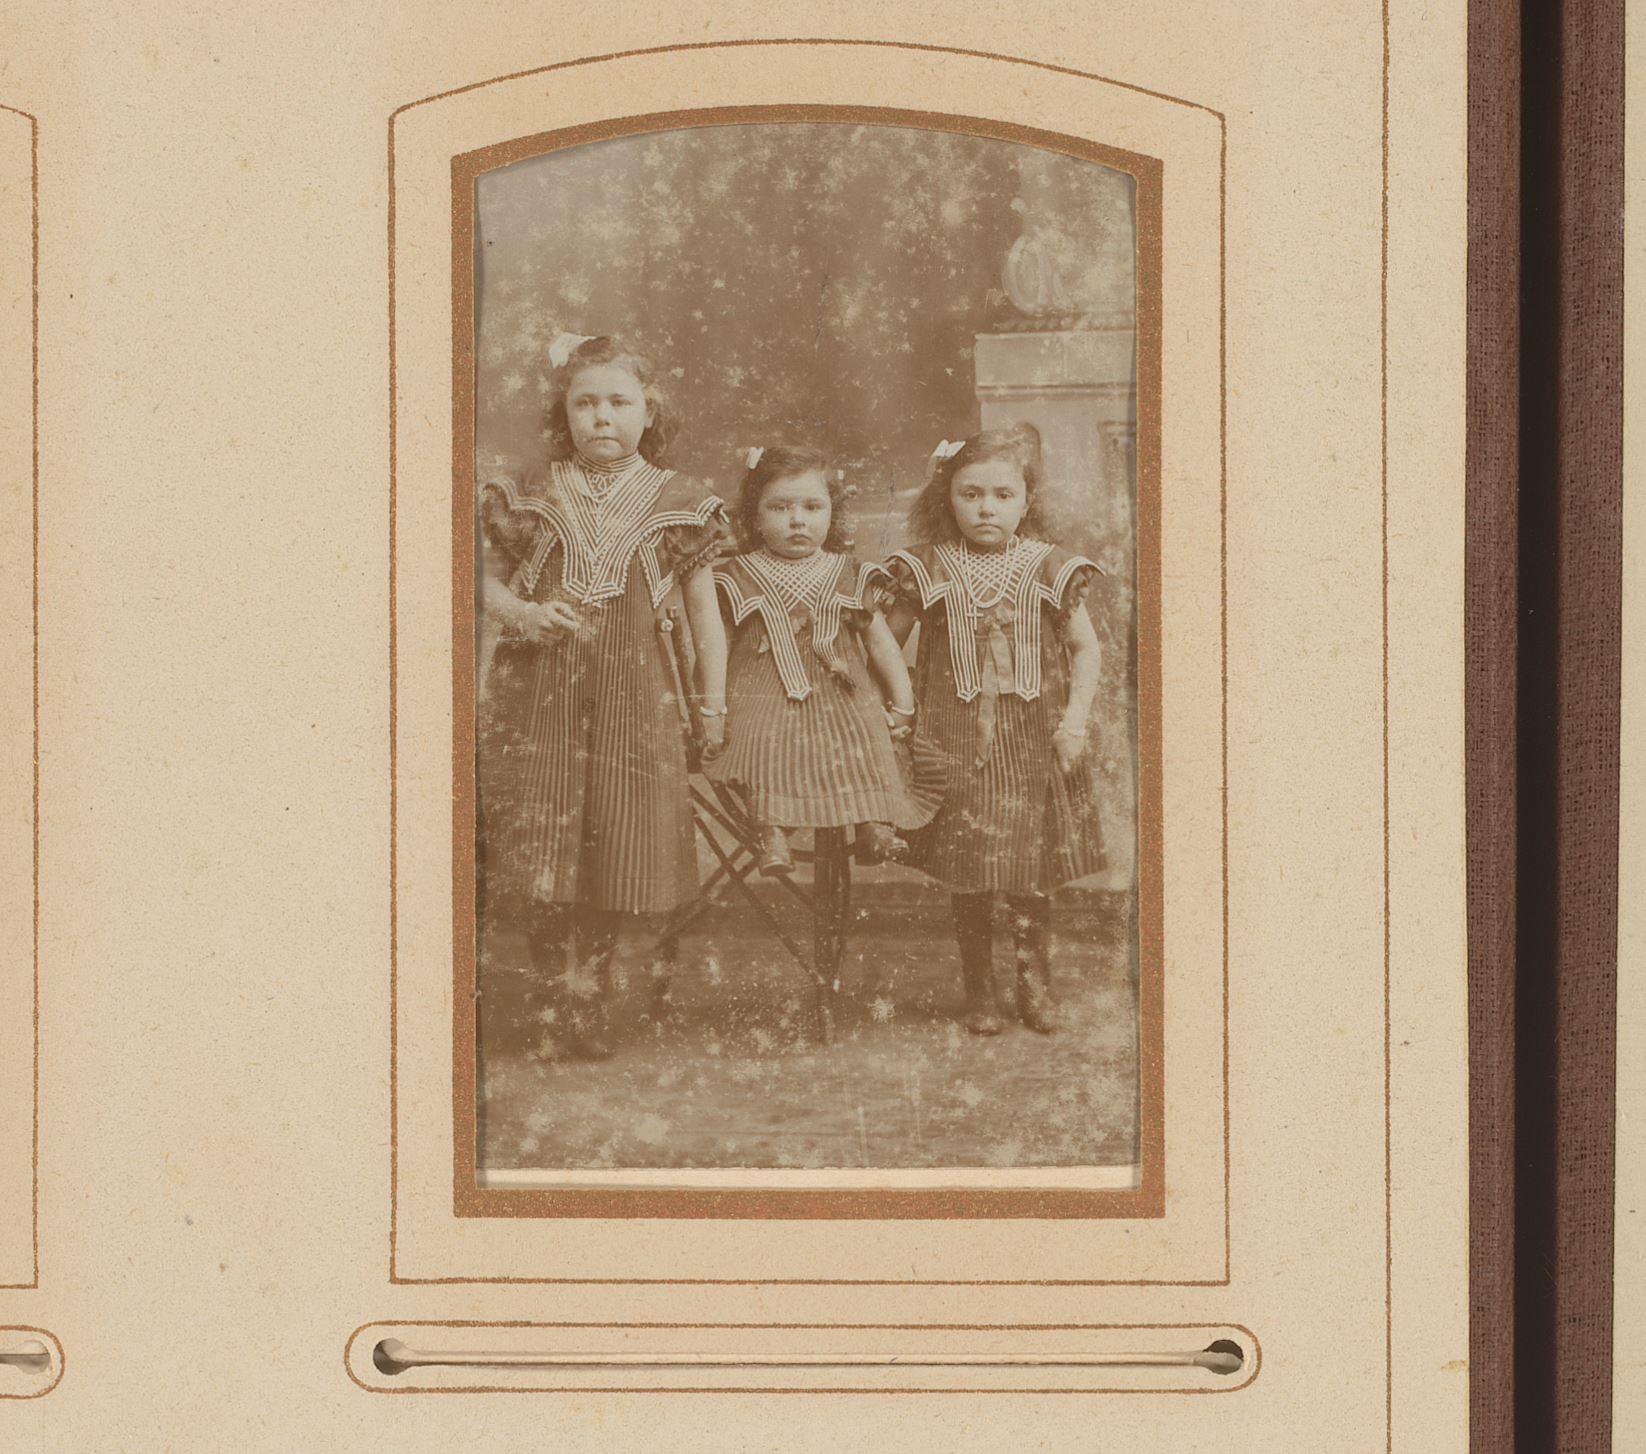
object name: album leaf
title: Portret van drie meisjes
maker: jan van roon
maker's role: fotograaf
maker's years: 1879-1948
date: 1903-1940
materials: cardboard, photographic support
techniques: collodion silver print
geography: haarlem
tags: girl (child between toddler and youth)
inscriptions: inscription: ‘Atelier van Roon/ Gen. Cronjéstr. 43, Haarlem’